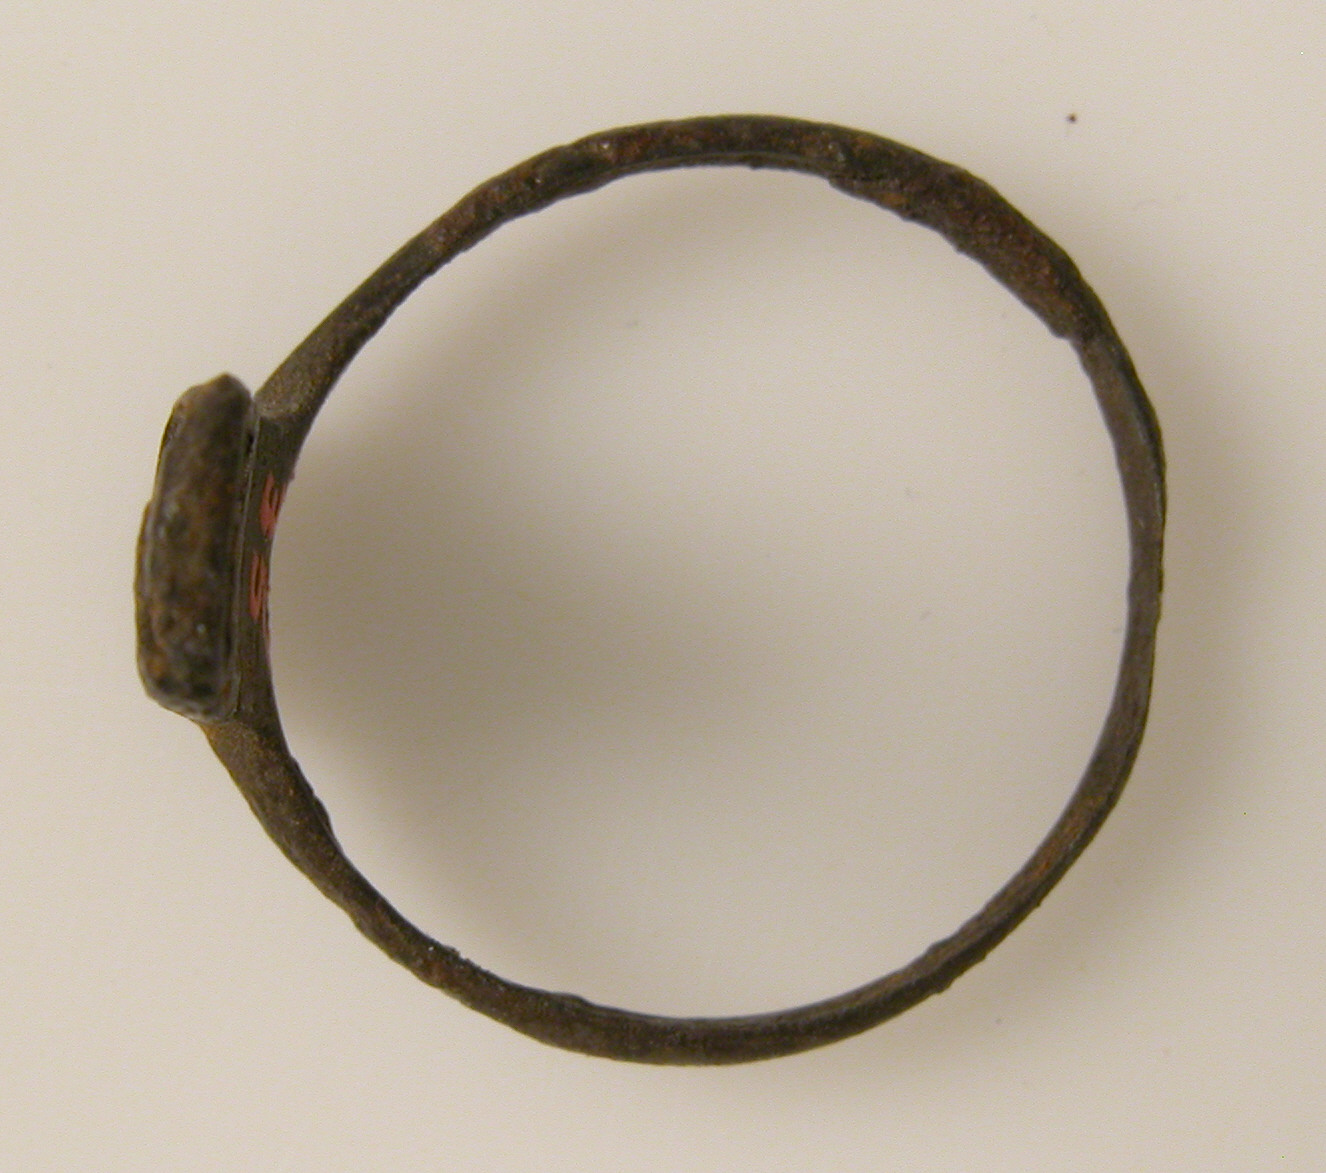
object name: ring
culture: coptic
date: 301-400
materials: iron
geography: egypt